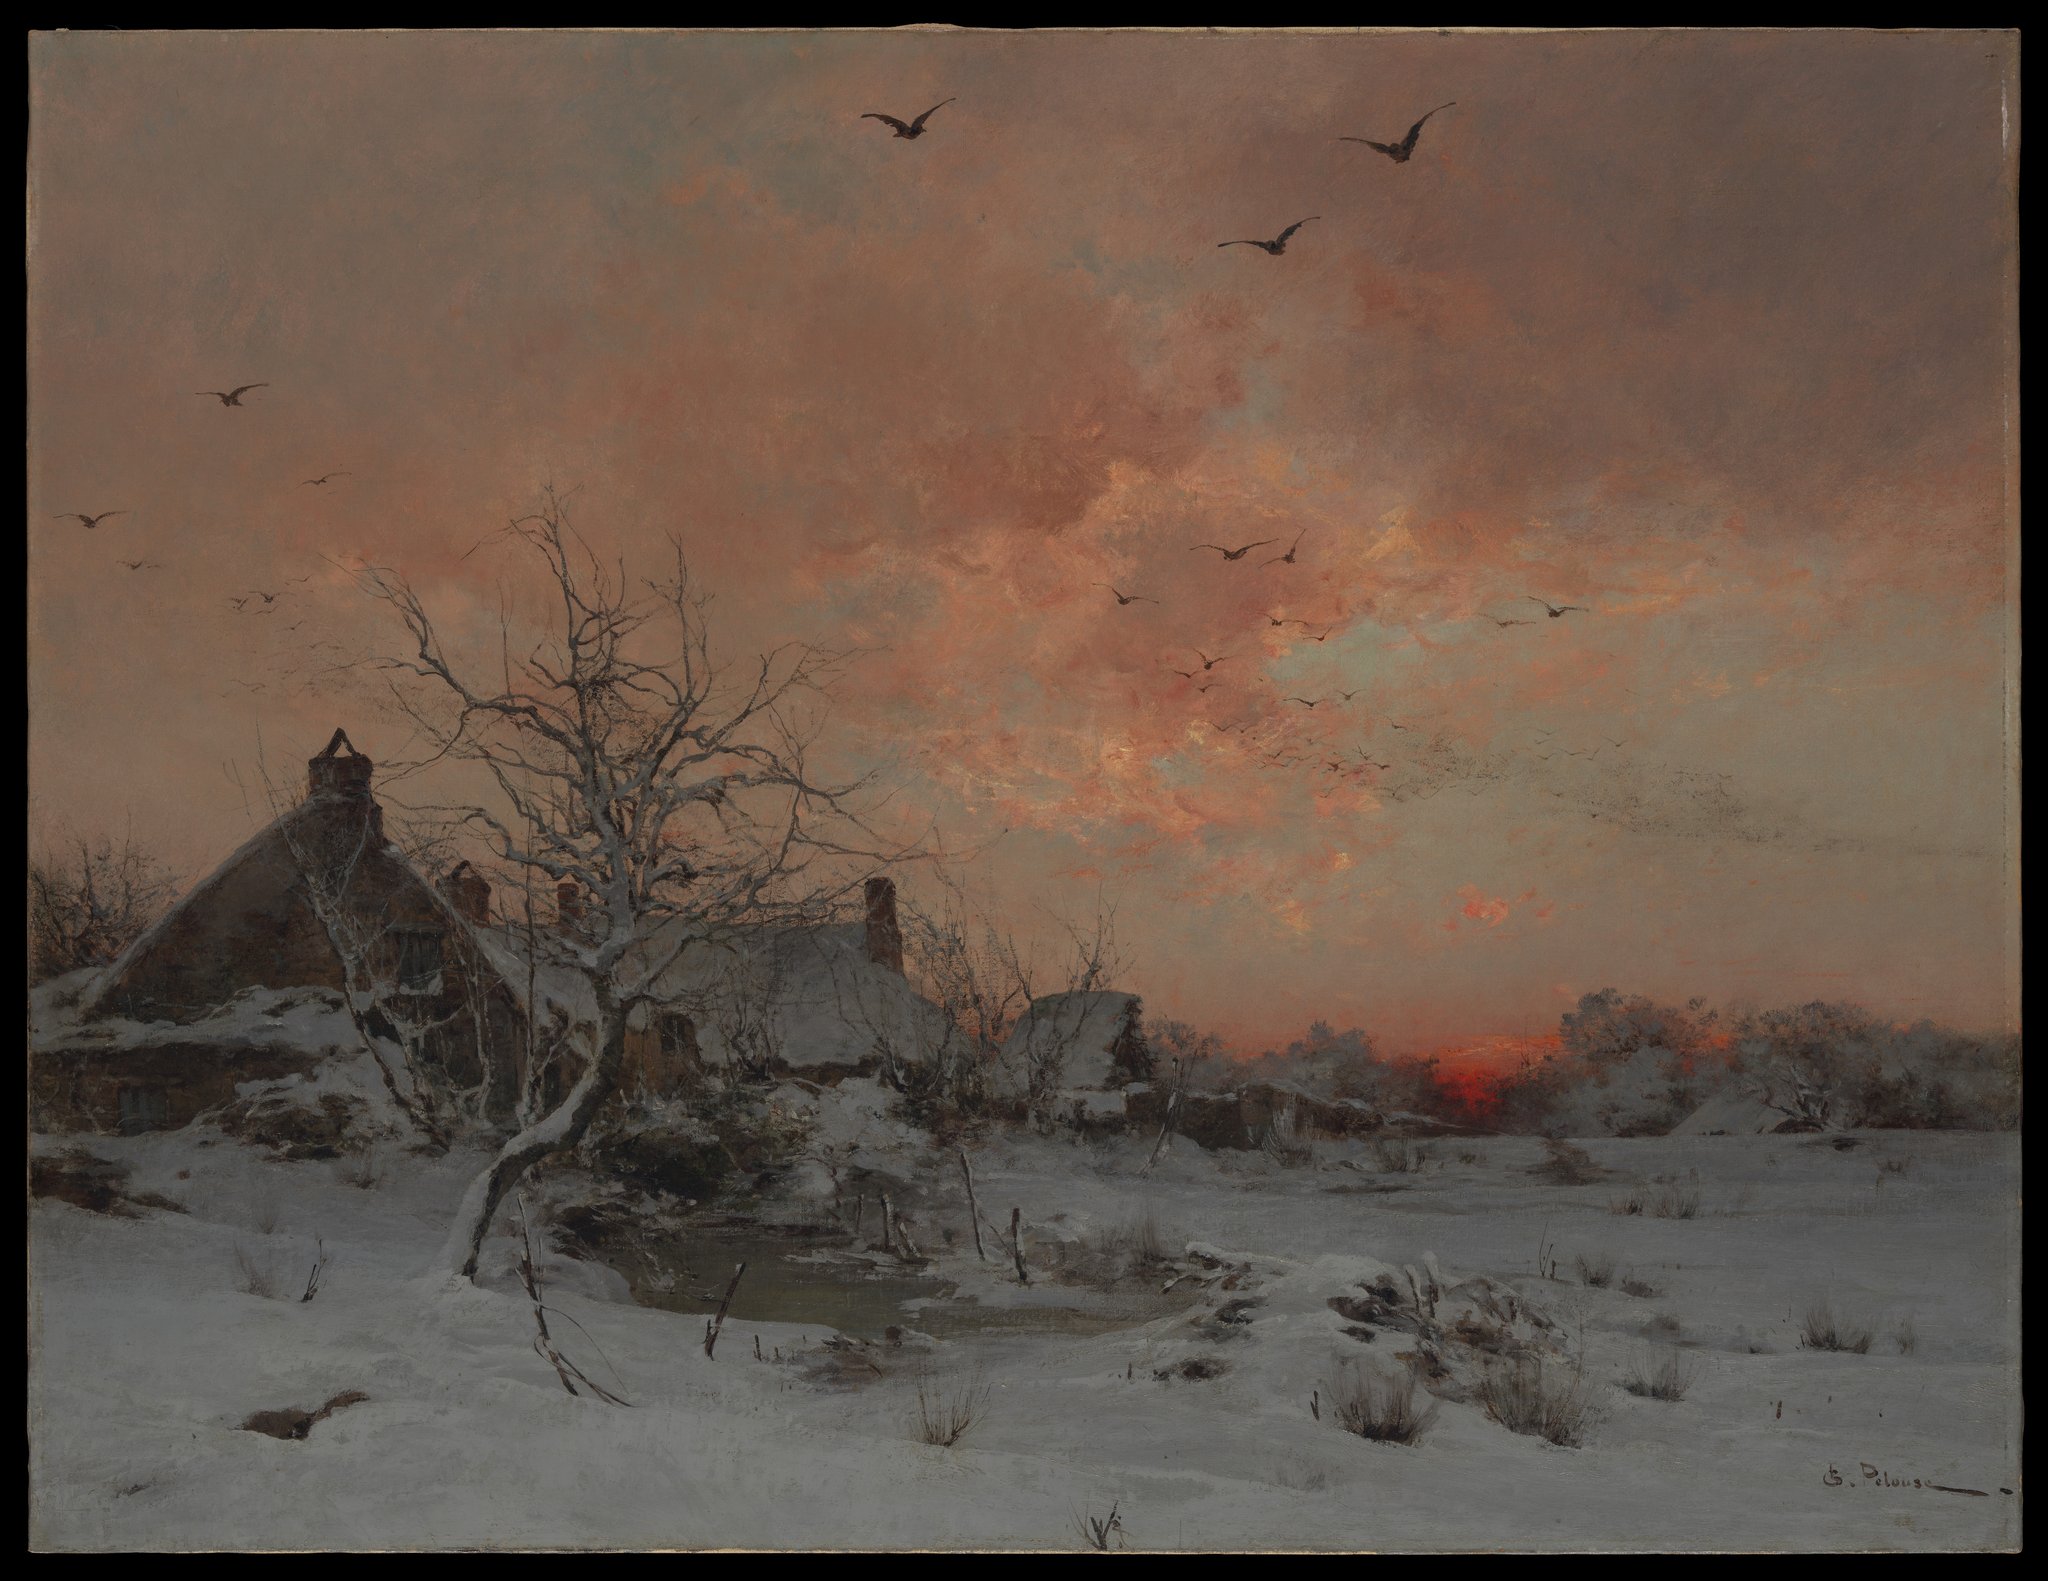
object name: painting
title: January: Cernay, near Rambouillet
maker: léon-germain pelouse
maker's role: artist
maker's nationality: french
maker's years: 1838-1891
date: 1858-1891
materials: canvas, oil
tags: landscapes,winter,snow